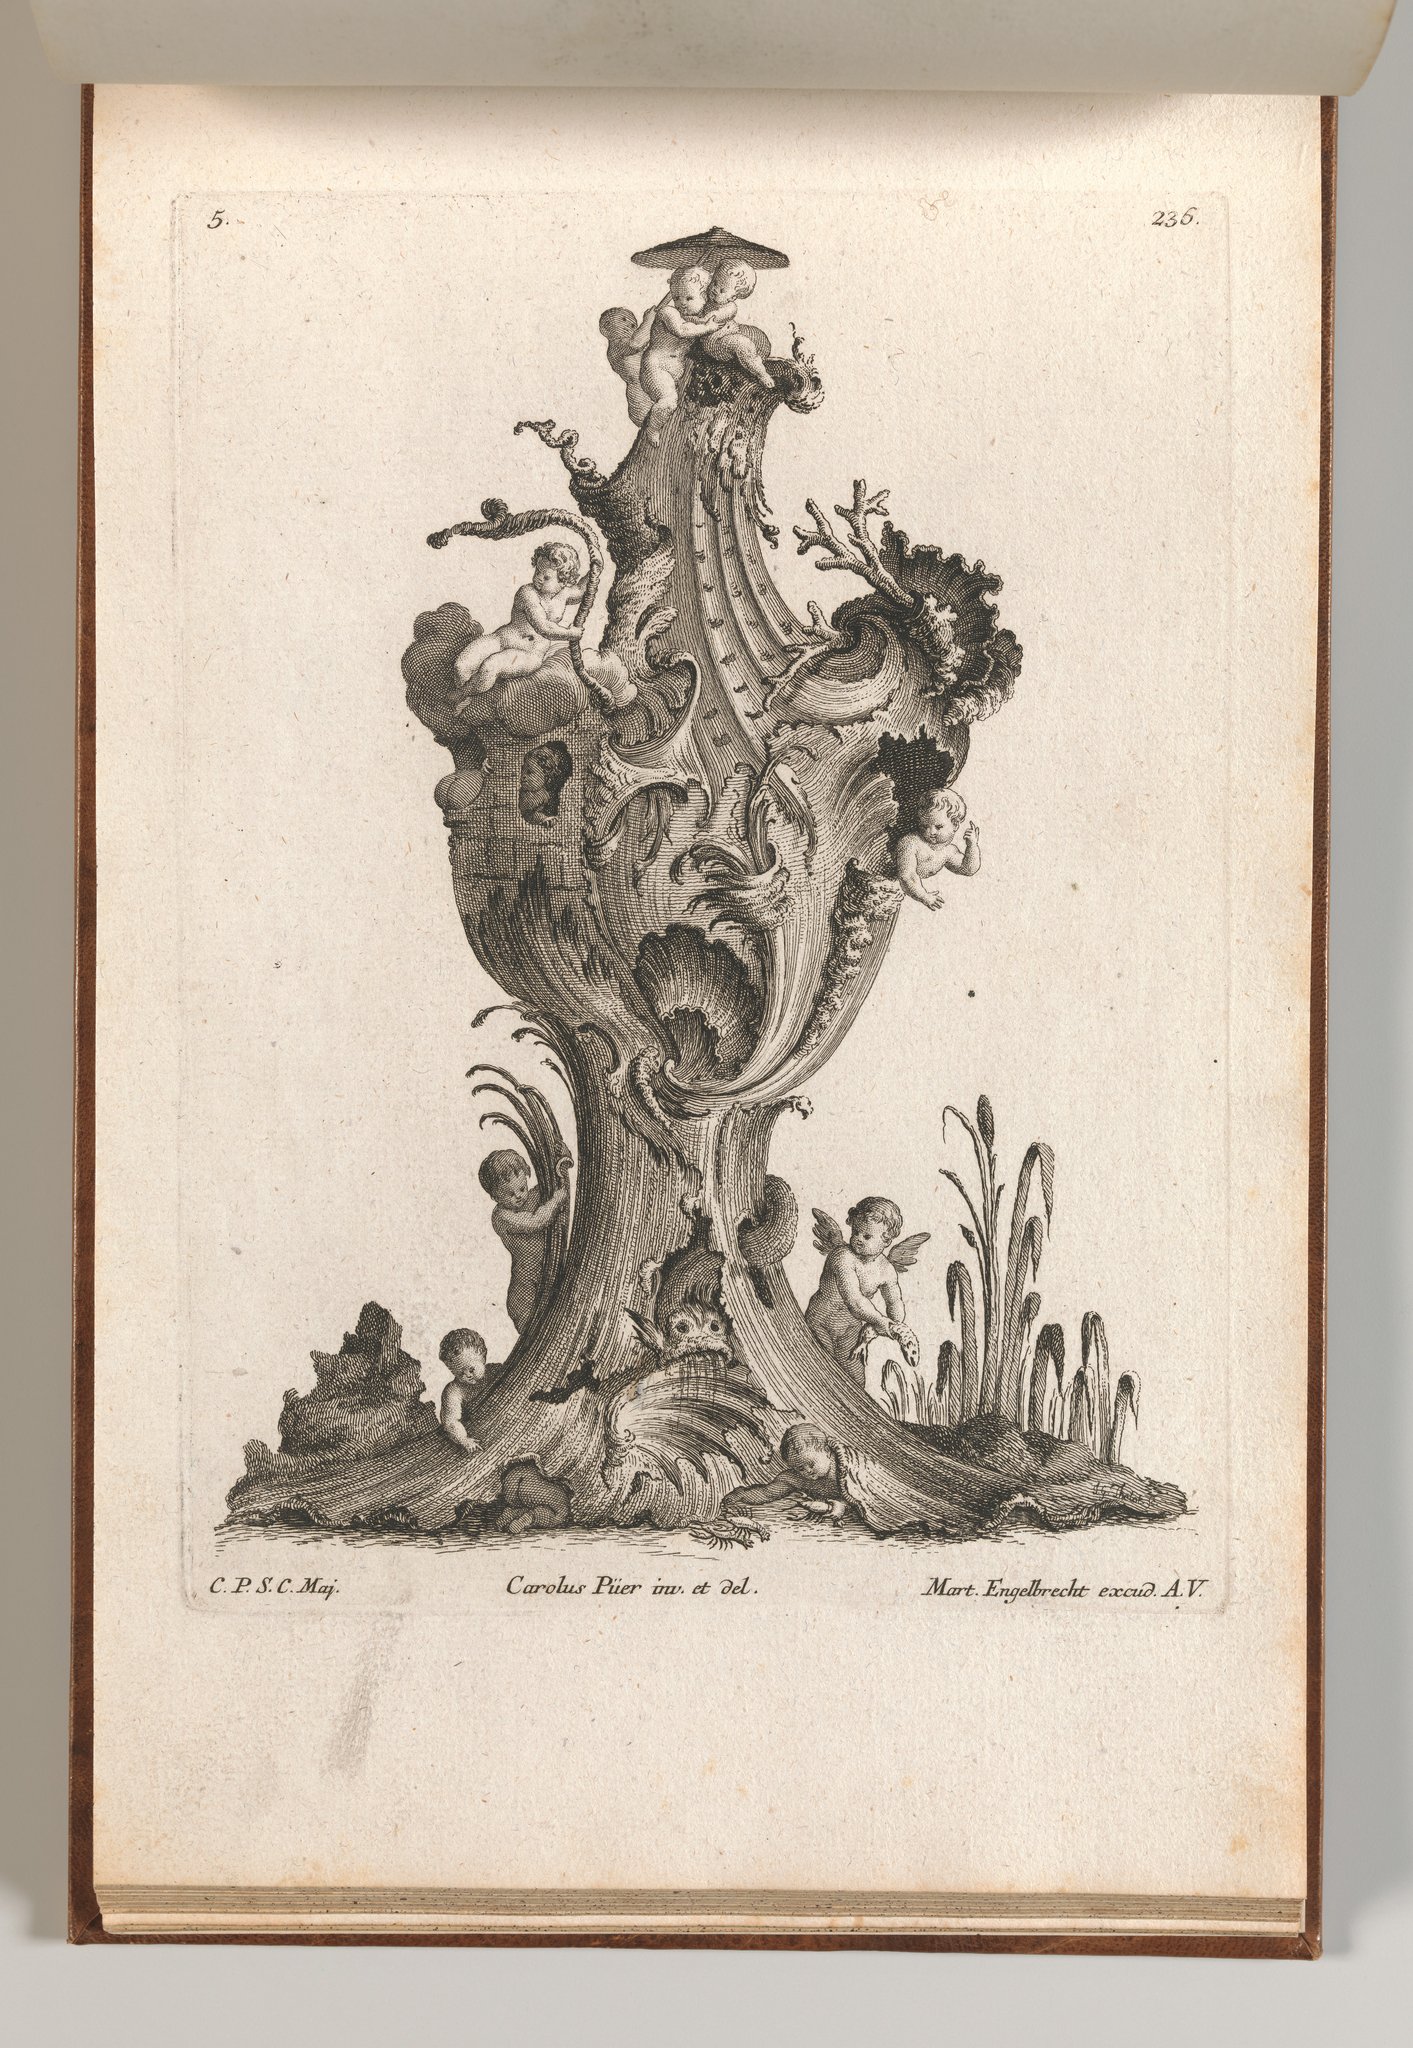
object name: album print ornament architecture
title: Design for a large Vase representing 'Water', Plate 5 from: 'Neu inventierte Vasi auf die neueste manier'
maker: jacob gottlieb thelot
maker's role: engraver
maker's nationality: central european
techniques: etching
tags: vases